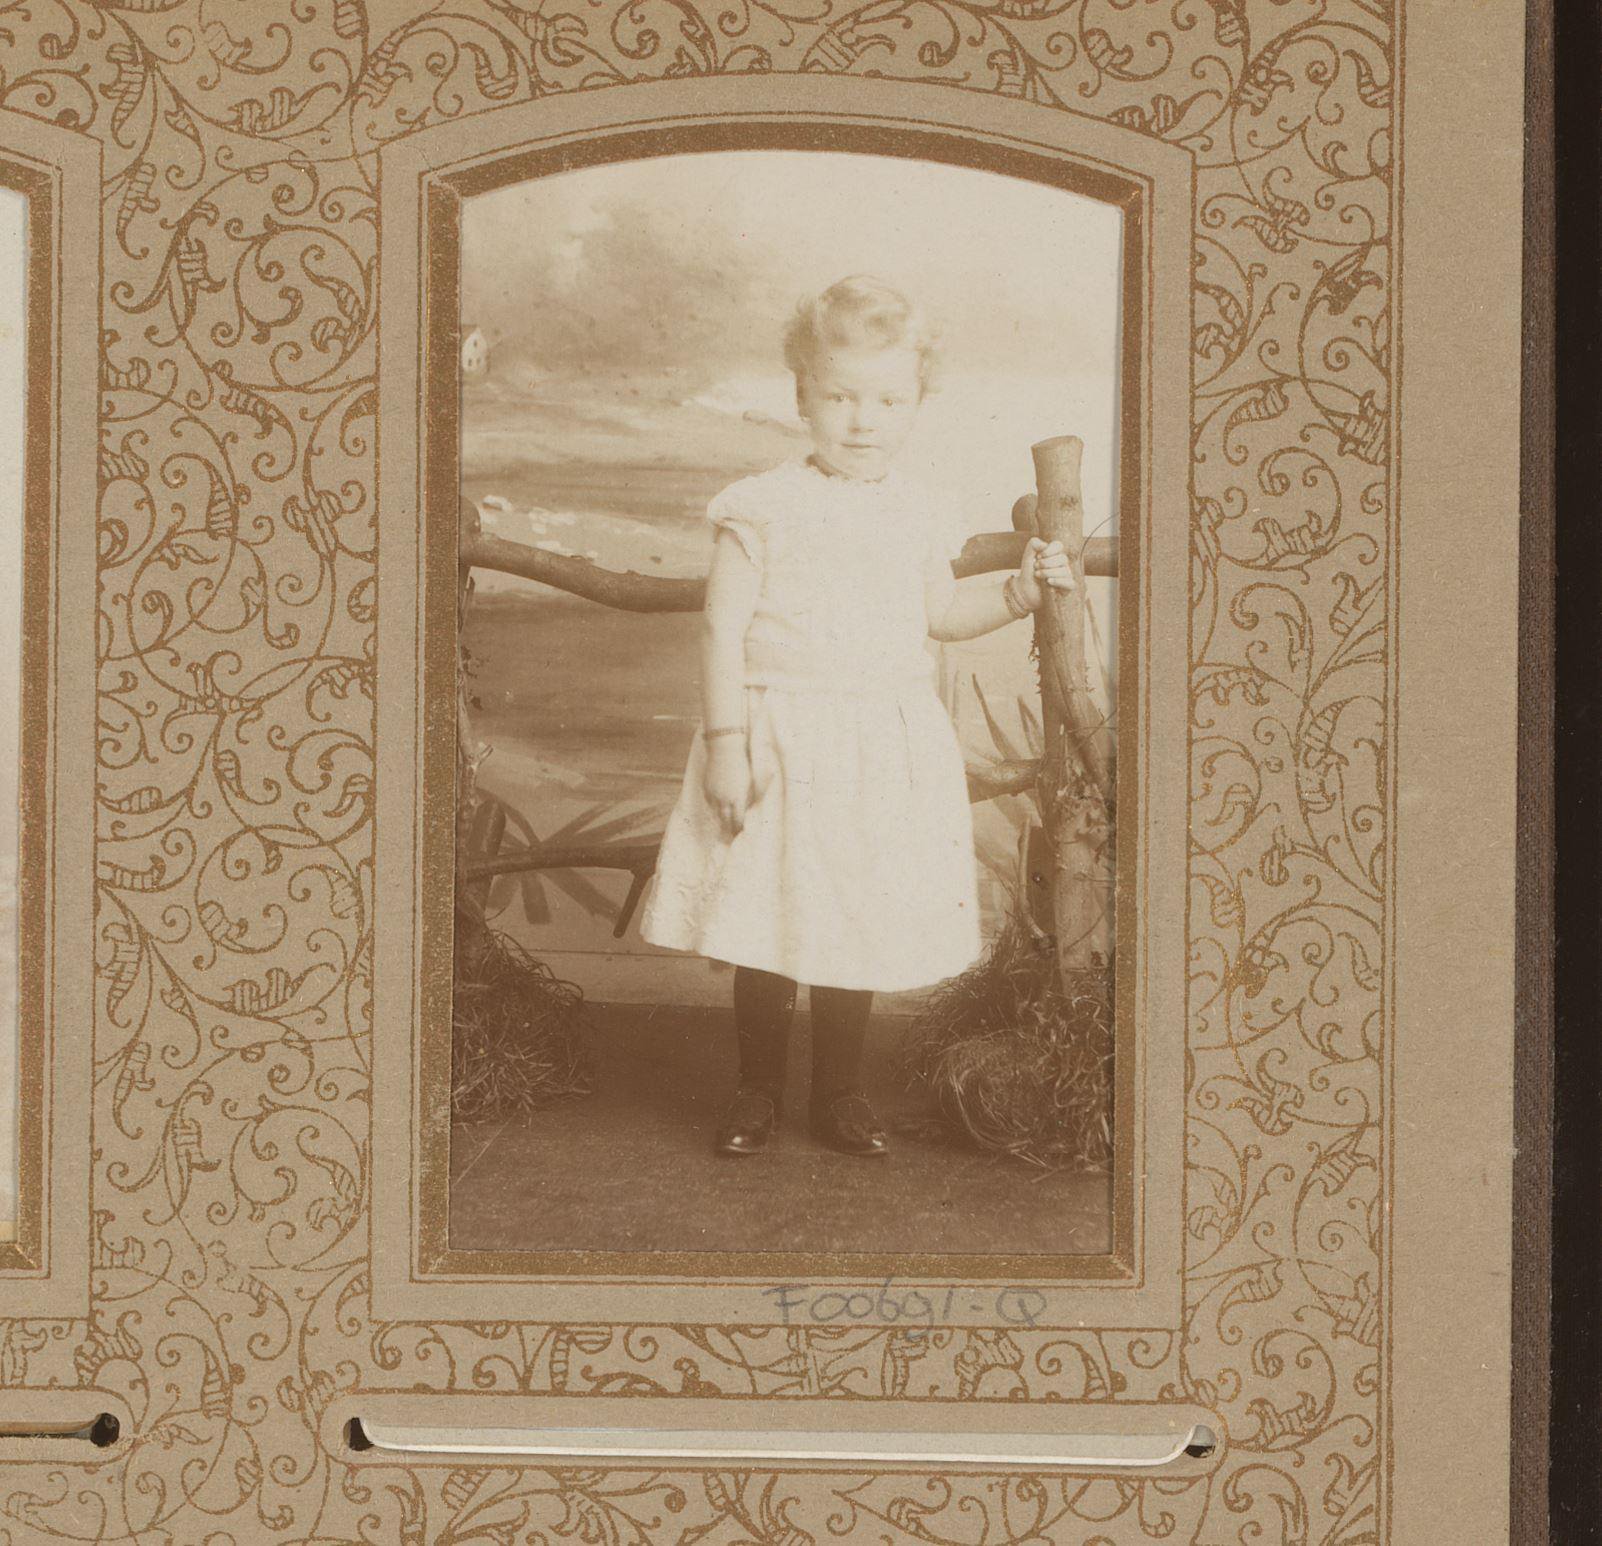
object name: album leaf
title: Portret van een meisje bij een hek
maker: hendrikus jakobus bast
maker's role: fotograaf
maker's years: 1870-1925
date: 1890-1910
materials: cardboard, photographic support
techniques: gelatin silver print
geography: amersfoort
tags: girl (child between toddler and youth)